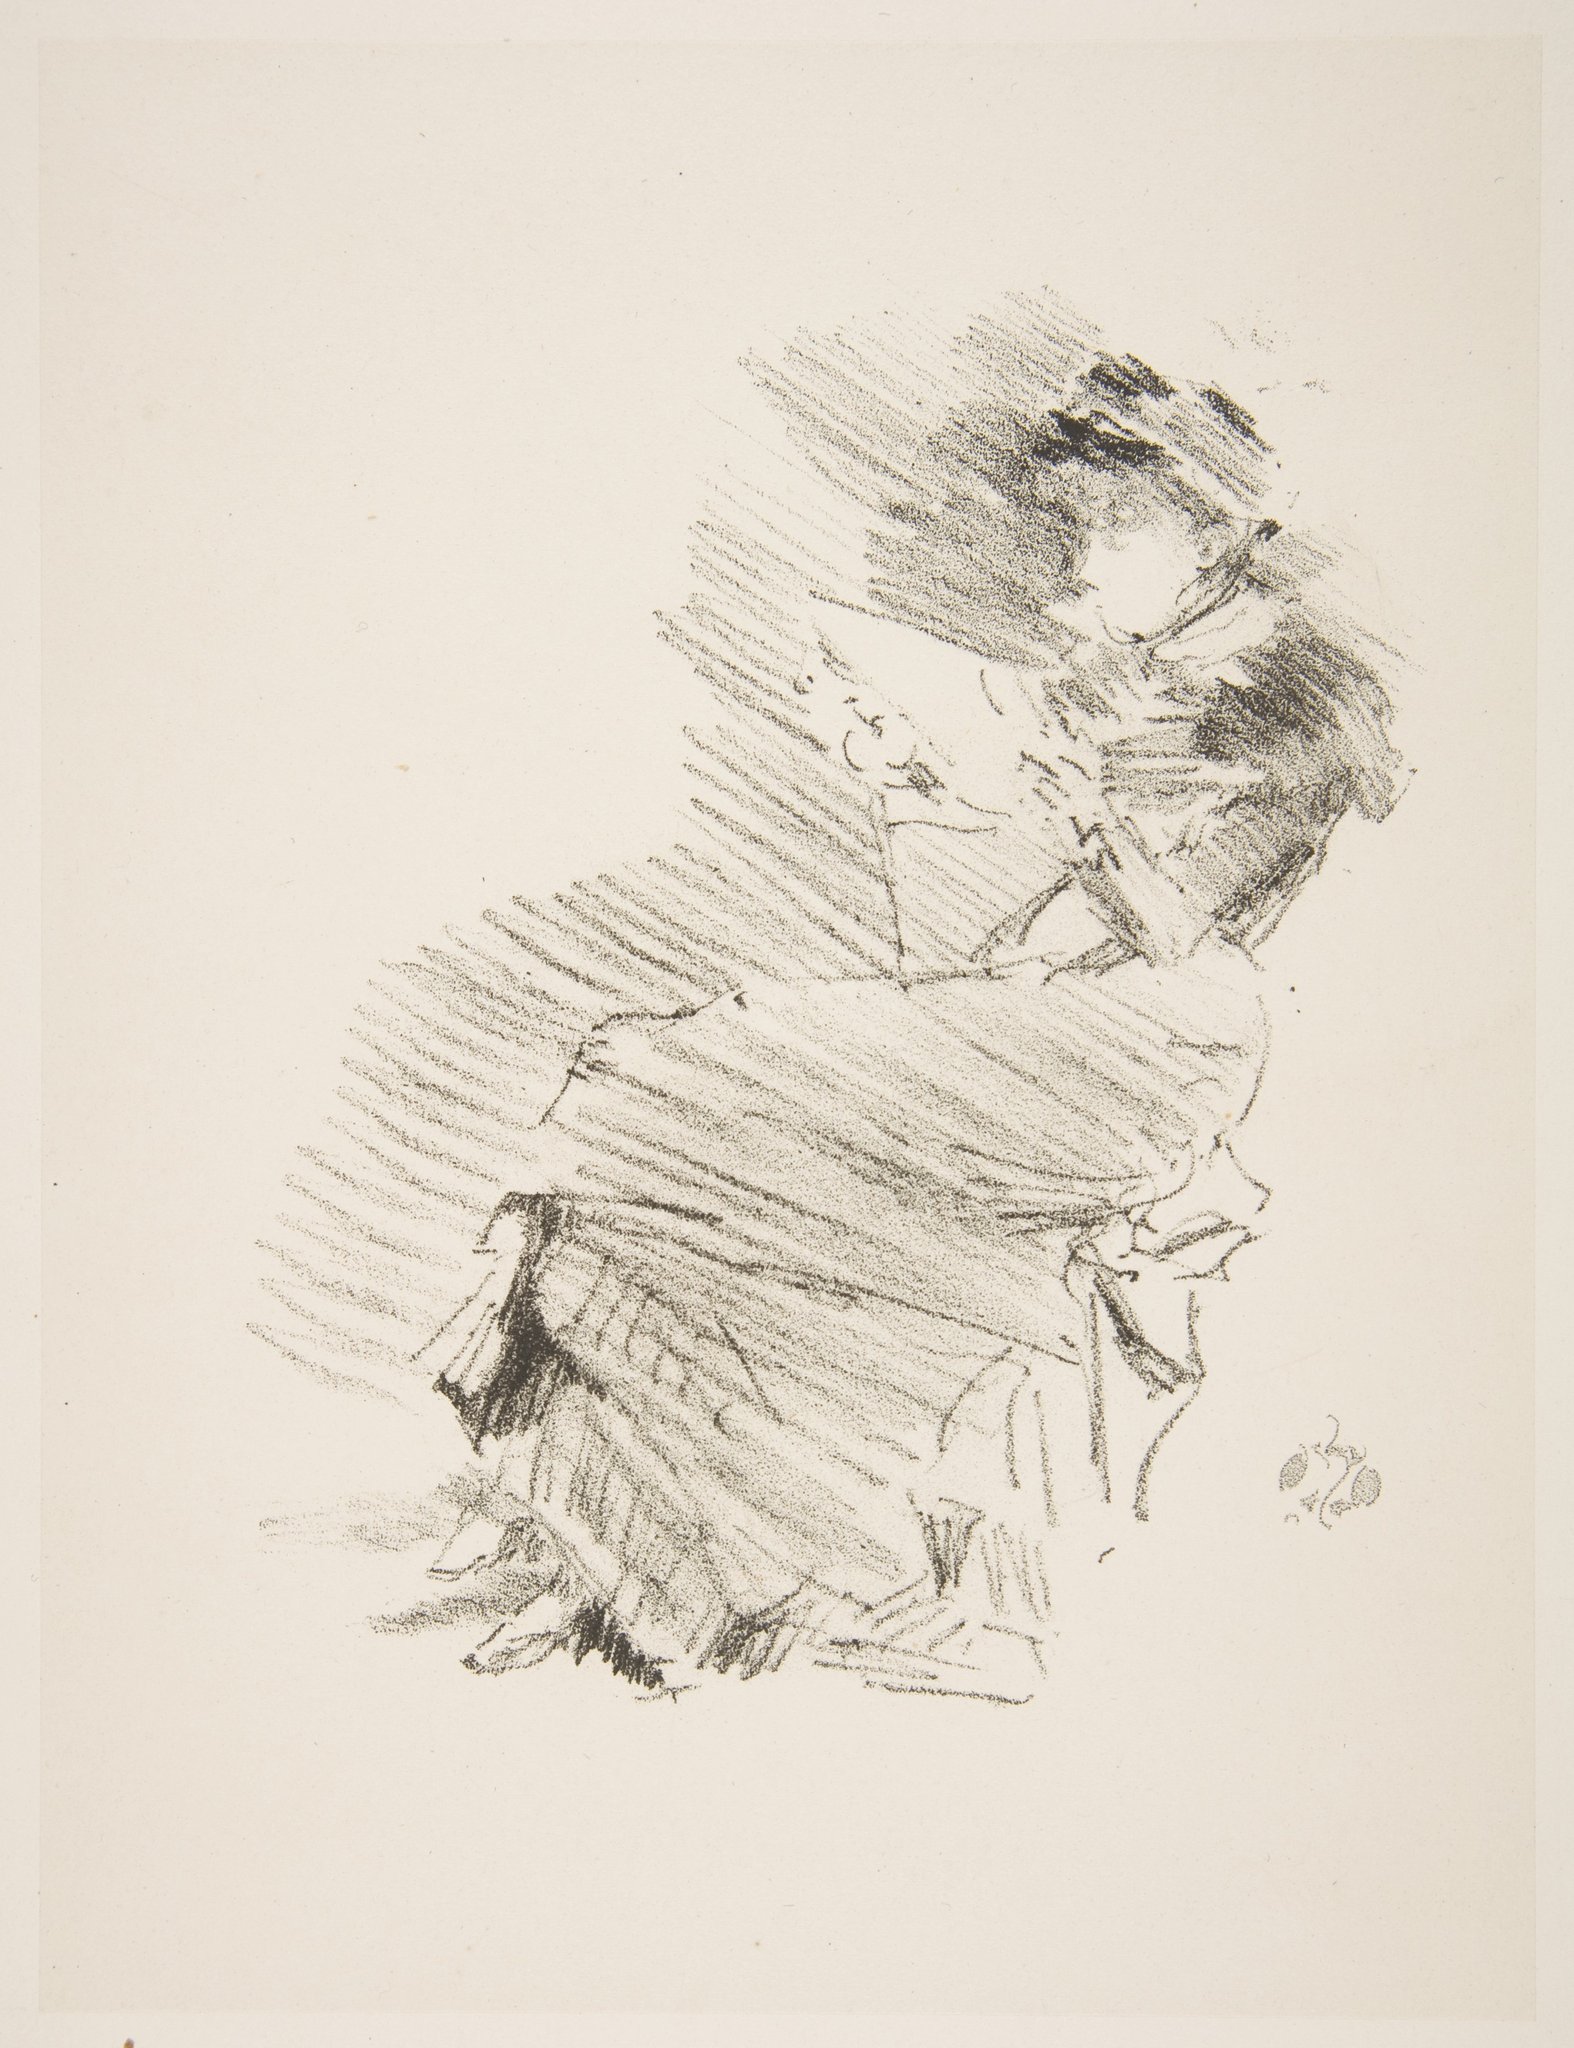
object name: print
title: Reading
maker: james mcneill whistler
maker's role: artist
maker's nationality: american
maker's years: 1834-1903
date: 1879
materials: chine, ink, paper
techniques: lithograph, printing, scraping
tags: women,reading